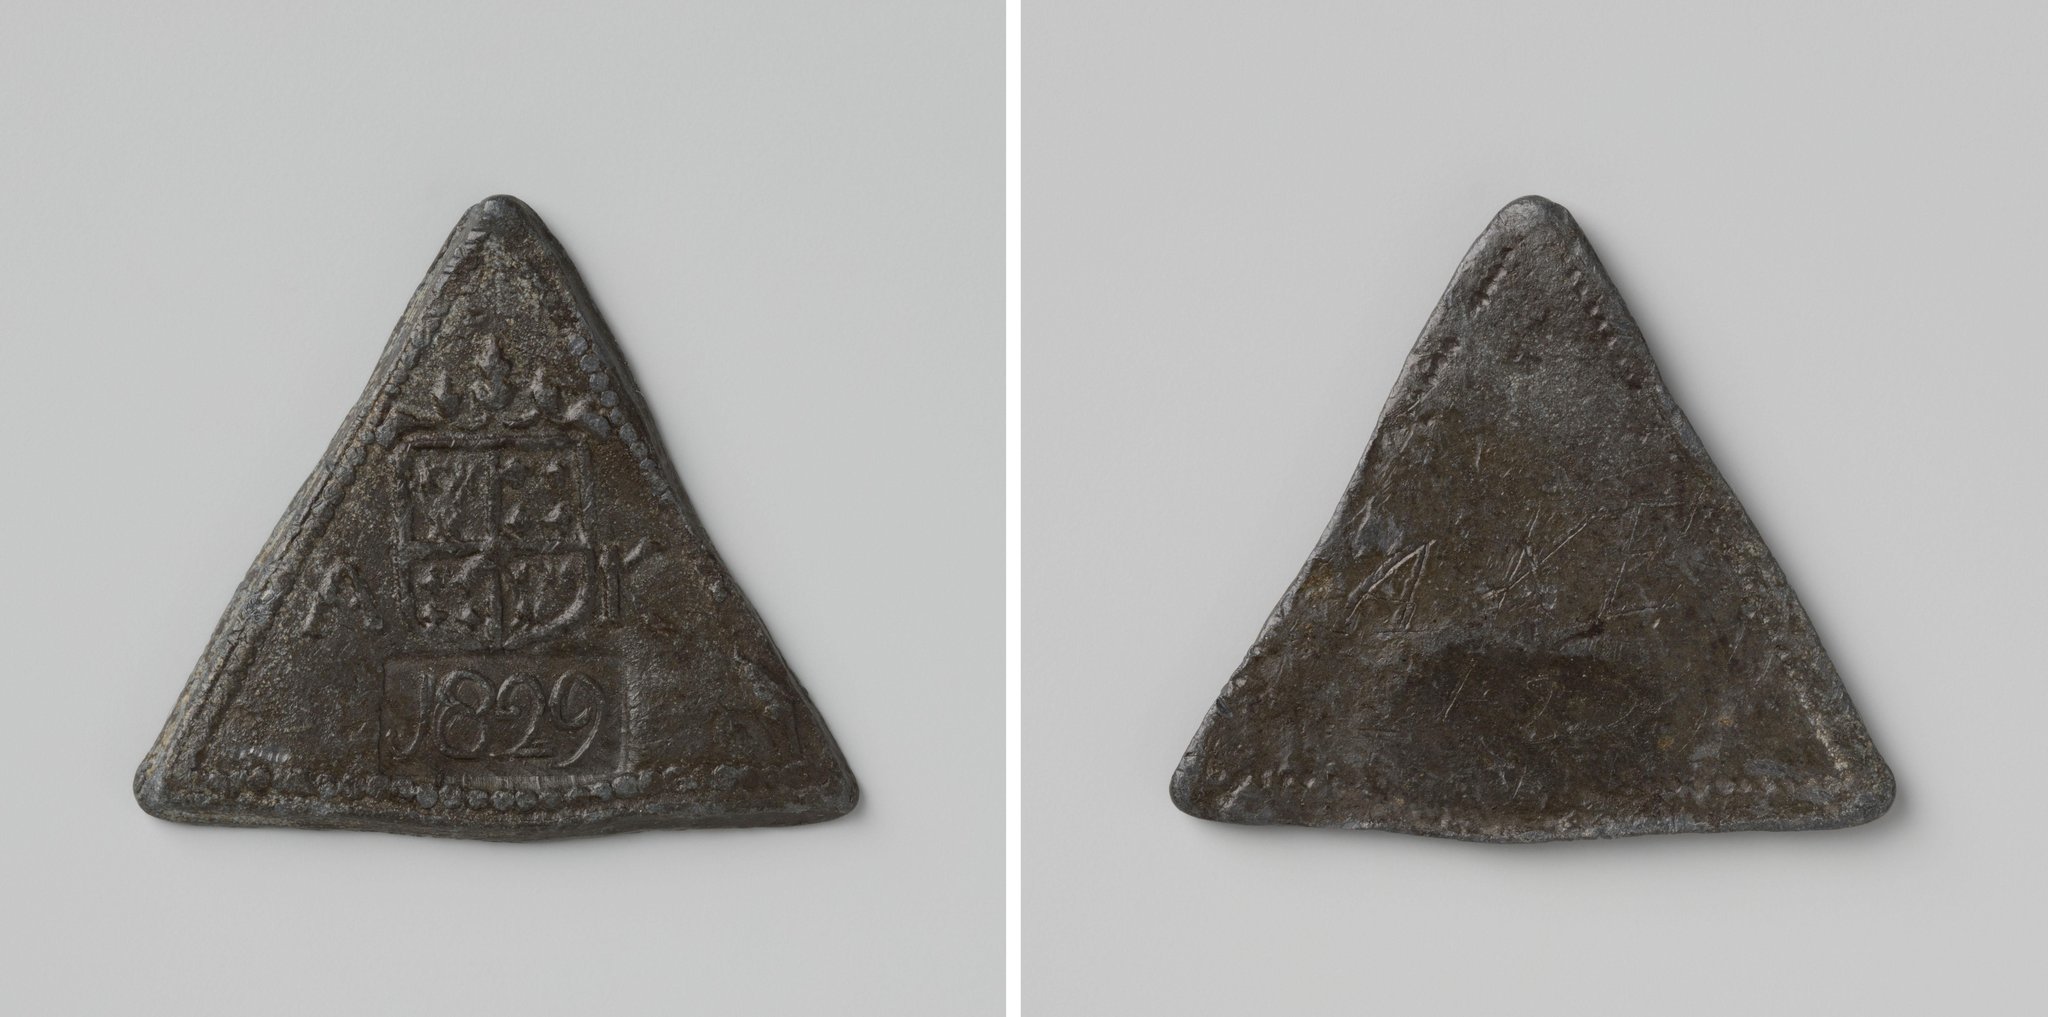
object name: tax token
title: Loodje om te plomberen met opschrift AK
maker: Anonymous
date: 1829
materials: lead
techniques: striking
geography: netherlands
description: eenzijdig, driehoekig loodje. Voorzijde: wapenschild tussen letters A en K boven jaartal in compartiment binnen parelrand. Keerzijde: ingekrast: letters A, K en E